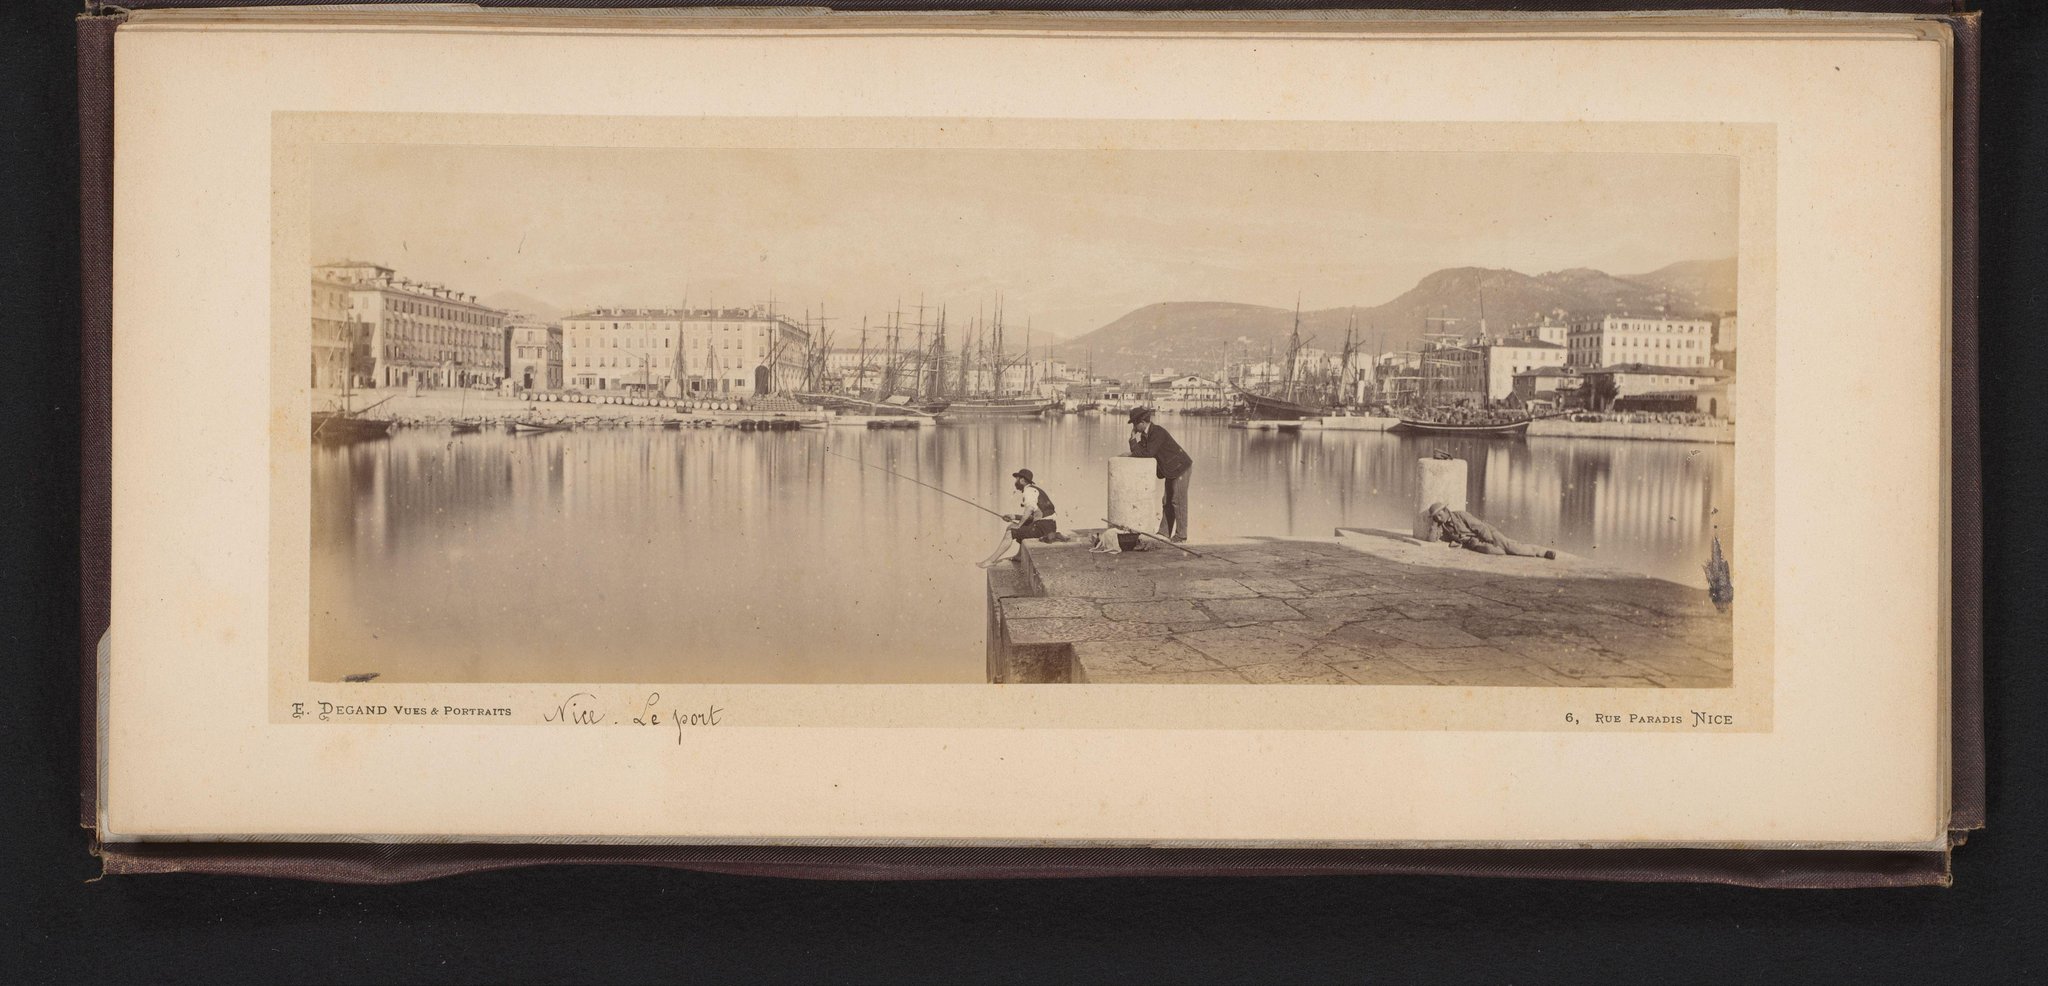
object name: photograph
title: Album Nice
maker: eugène degand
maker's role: painter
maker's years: 1829-1911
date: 1872-1874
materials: cardboard, photographic support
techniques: albumen print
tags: harbour, sailing-ship, sailing-boat, fisherman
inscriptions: annotation: ‘Nice, Le port’, inscription: ‘E. Degand Vues&Portraits 6, Rue Paradis Nice’